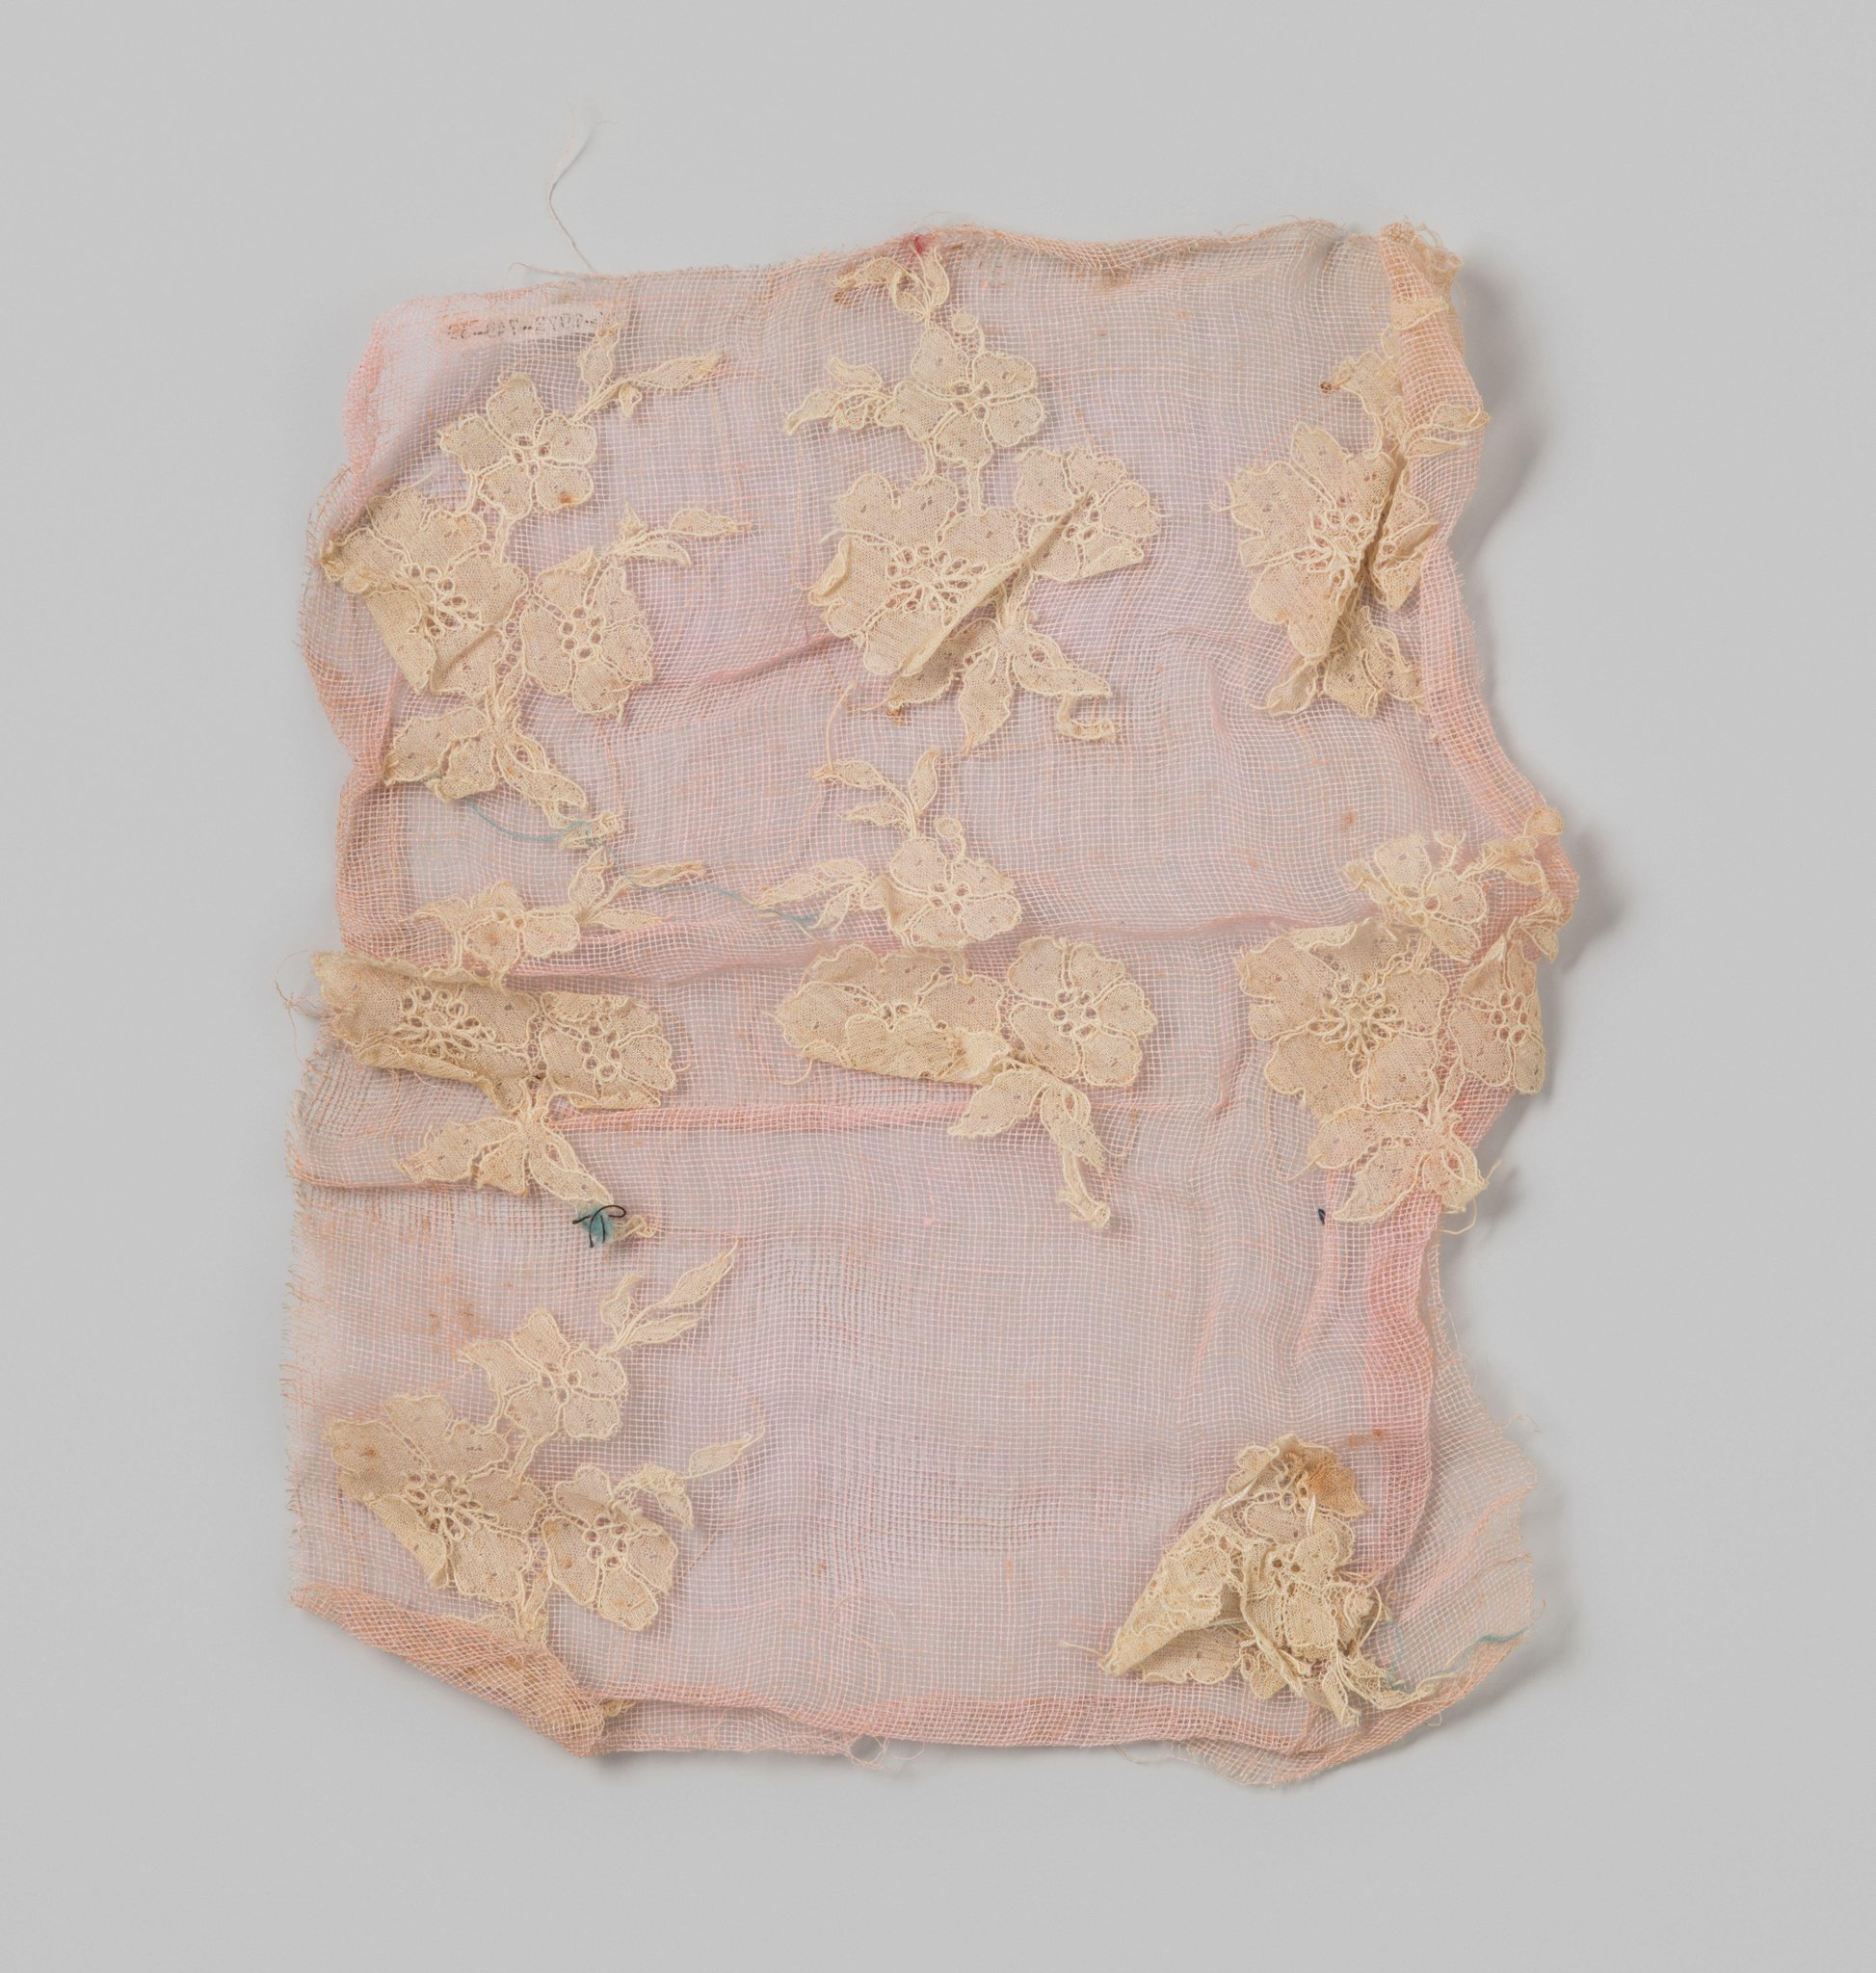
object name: strip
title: Strook rose stof met witte applicatiekant, zeer ruw bevestigd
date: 1920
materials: lace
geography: belgium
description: Strook rose stof met witte applicatiekant, zeer ruw bevestigd.